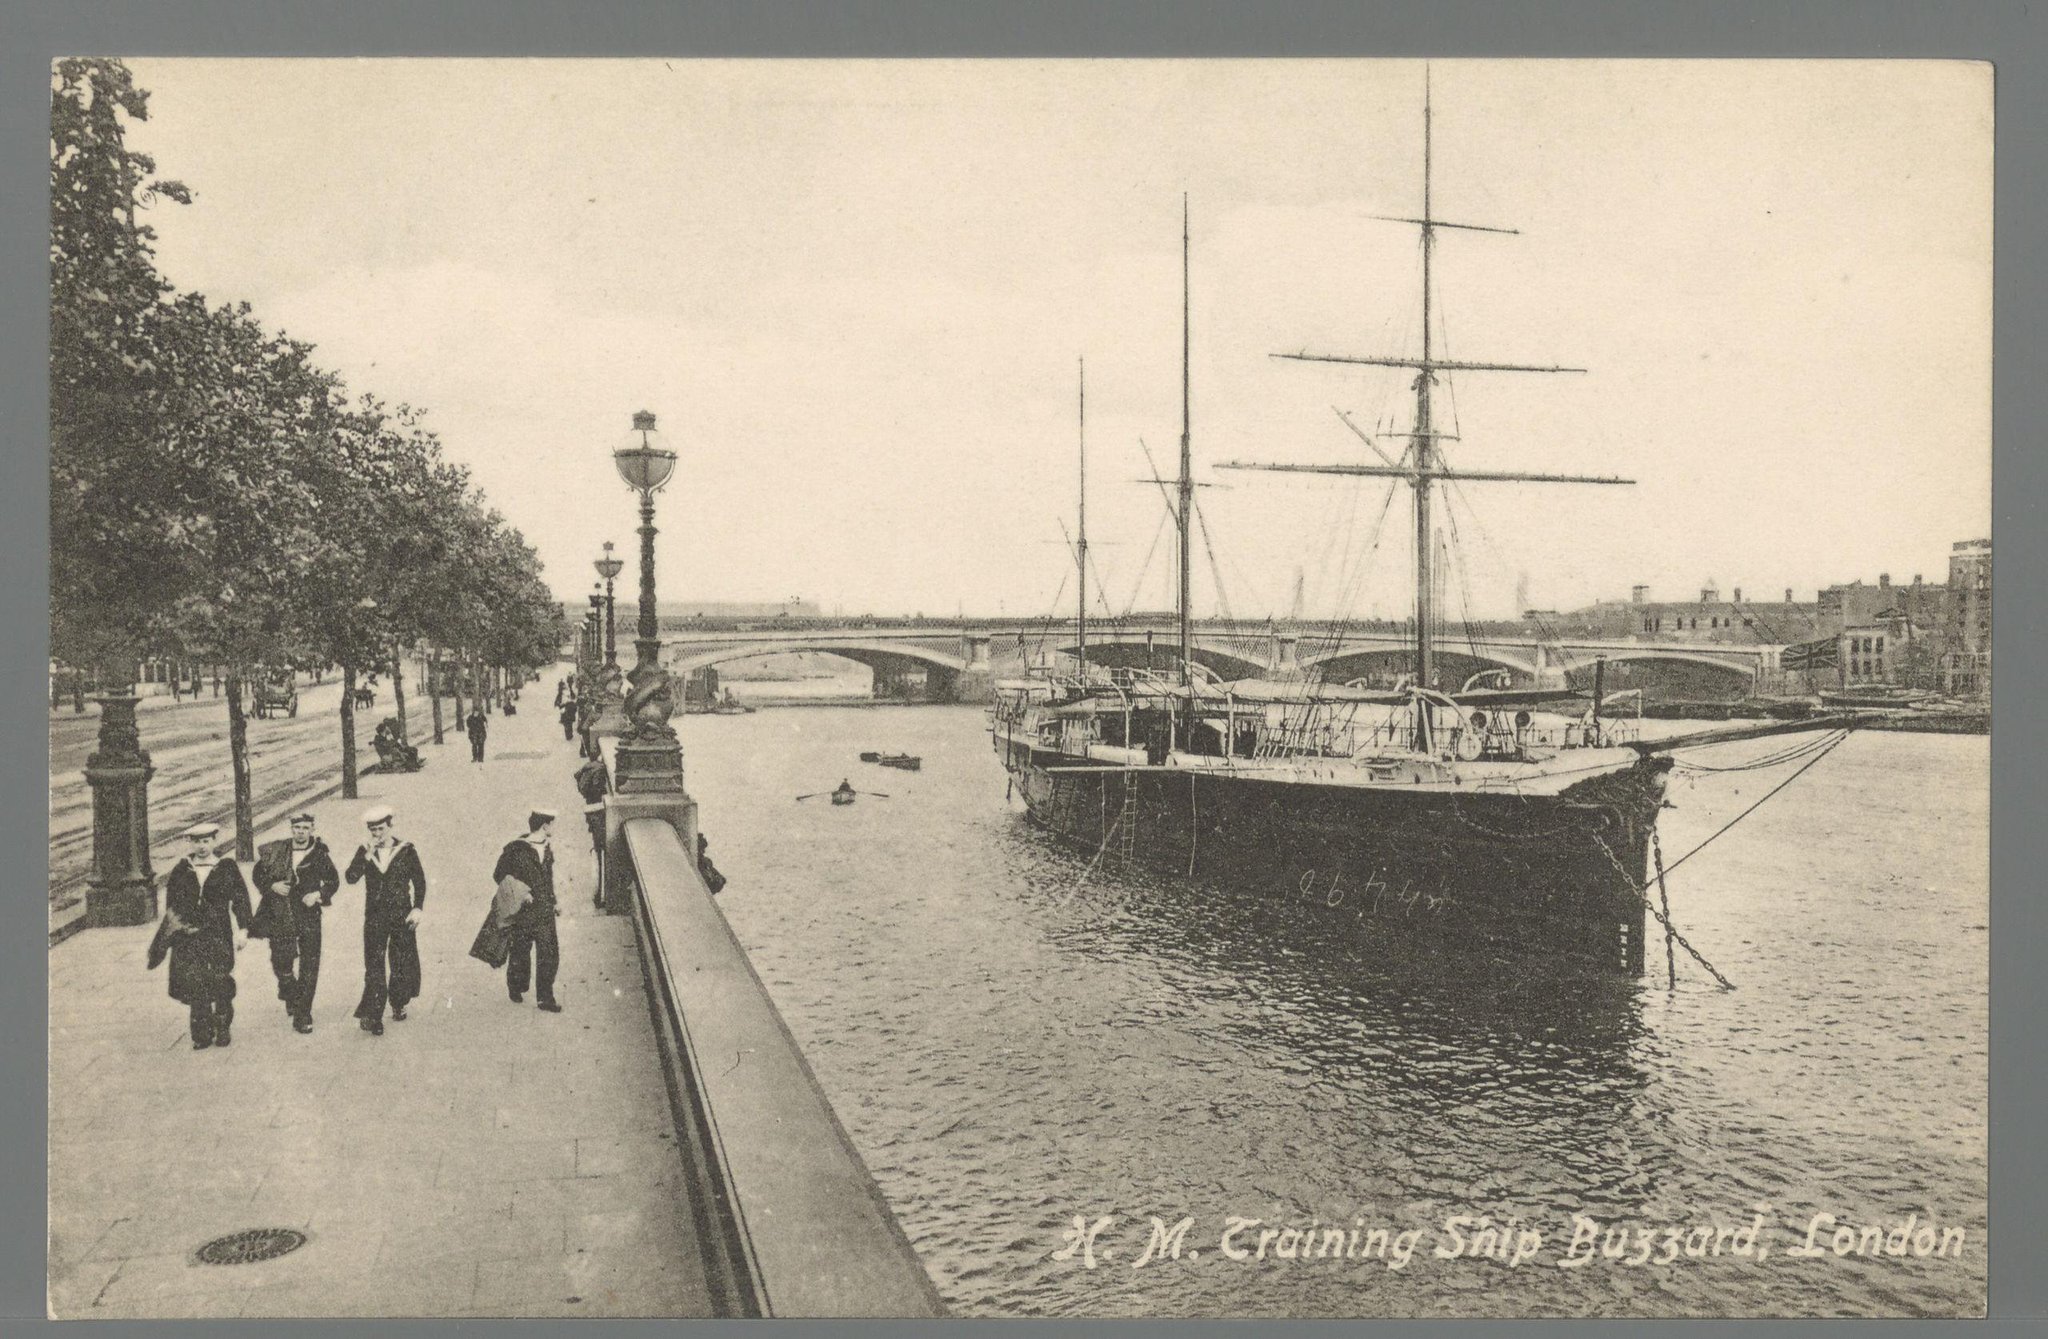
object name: photomechanical print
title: Valentine's Series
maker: Anonymous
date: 1902-1930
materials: cardboard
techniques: photograph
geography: london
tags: sailing-ship, sailing-boat, river, thames